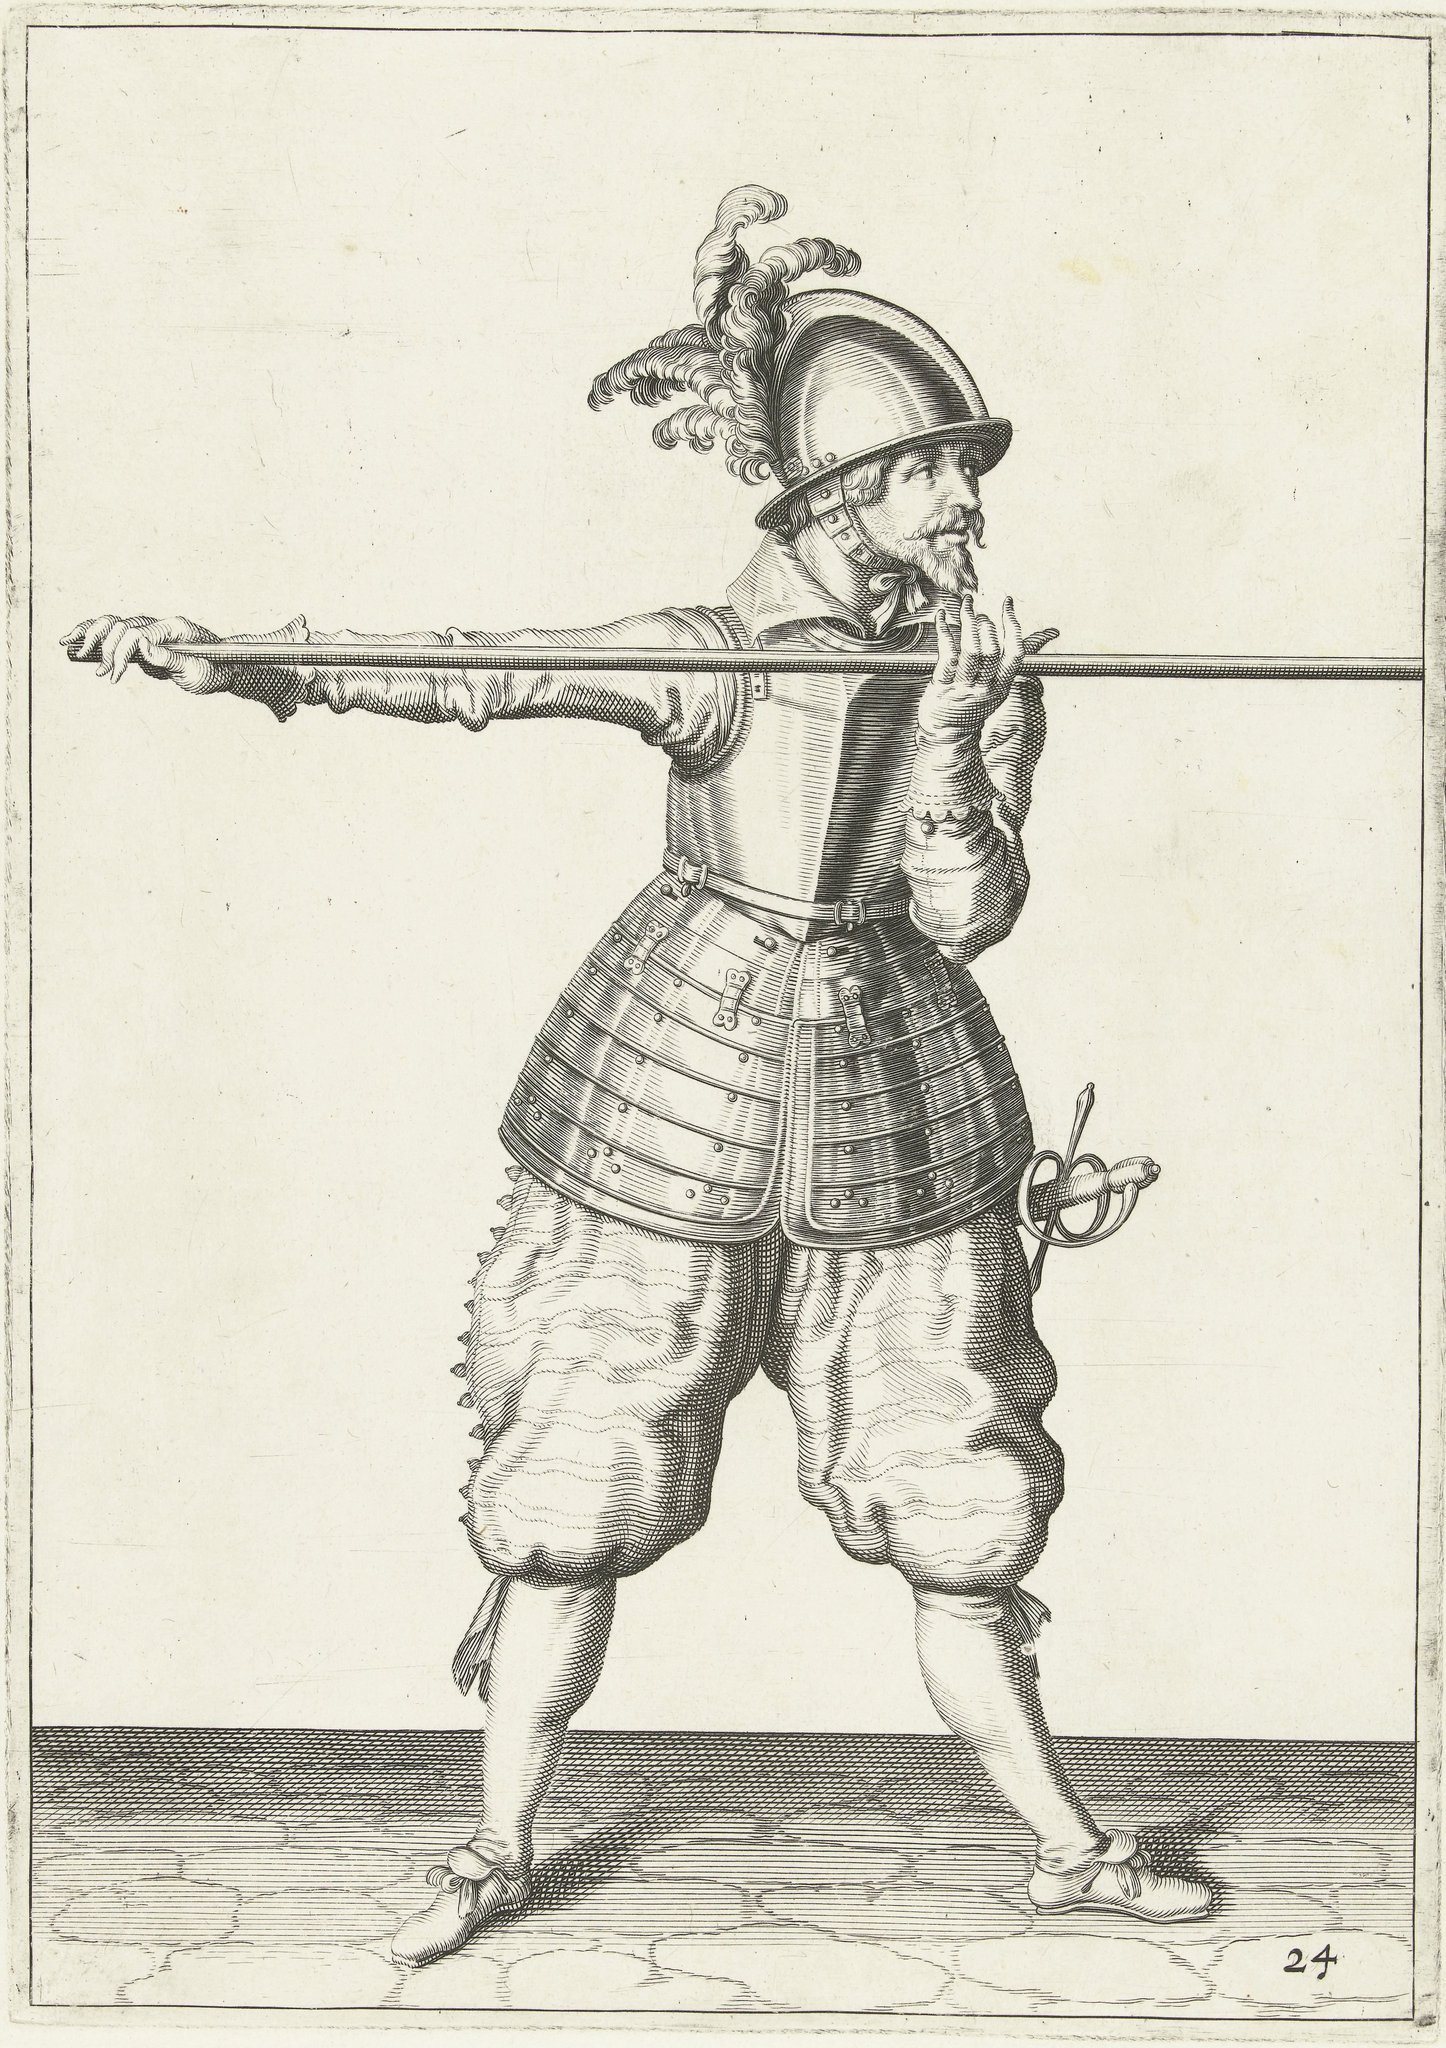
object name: print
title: Soldaat die zijn spies met beide handen horizontaal op schouderhoogte draagt, zijn rechterhand bij de voet van het wapen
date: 1597-1607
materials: paper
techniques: engraving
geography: netherlands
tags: manoeuvre ~ military training, warfare; military affairs (+ mercenary troops, e.g.: lansquenets), helved weapons, polearms (for striking, hacking, thrusting): lance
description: Een soldaat, ten voeten uit, die een spies (lans) met beide handen horizontaal op schouderhoogte draagt, zijn rechterhand bij de voet van het wapen. Deze prent is onderdeel van de reeks van 32 genummerde prenten van spiesdragers uit de Wapenhandelinghe.